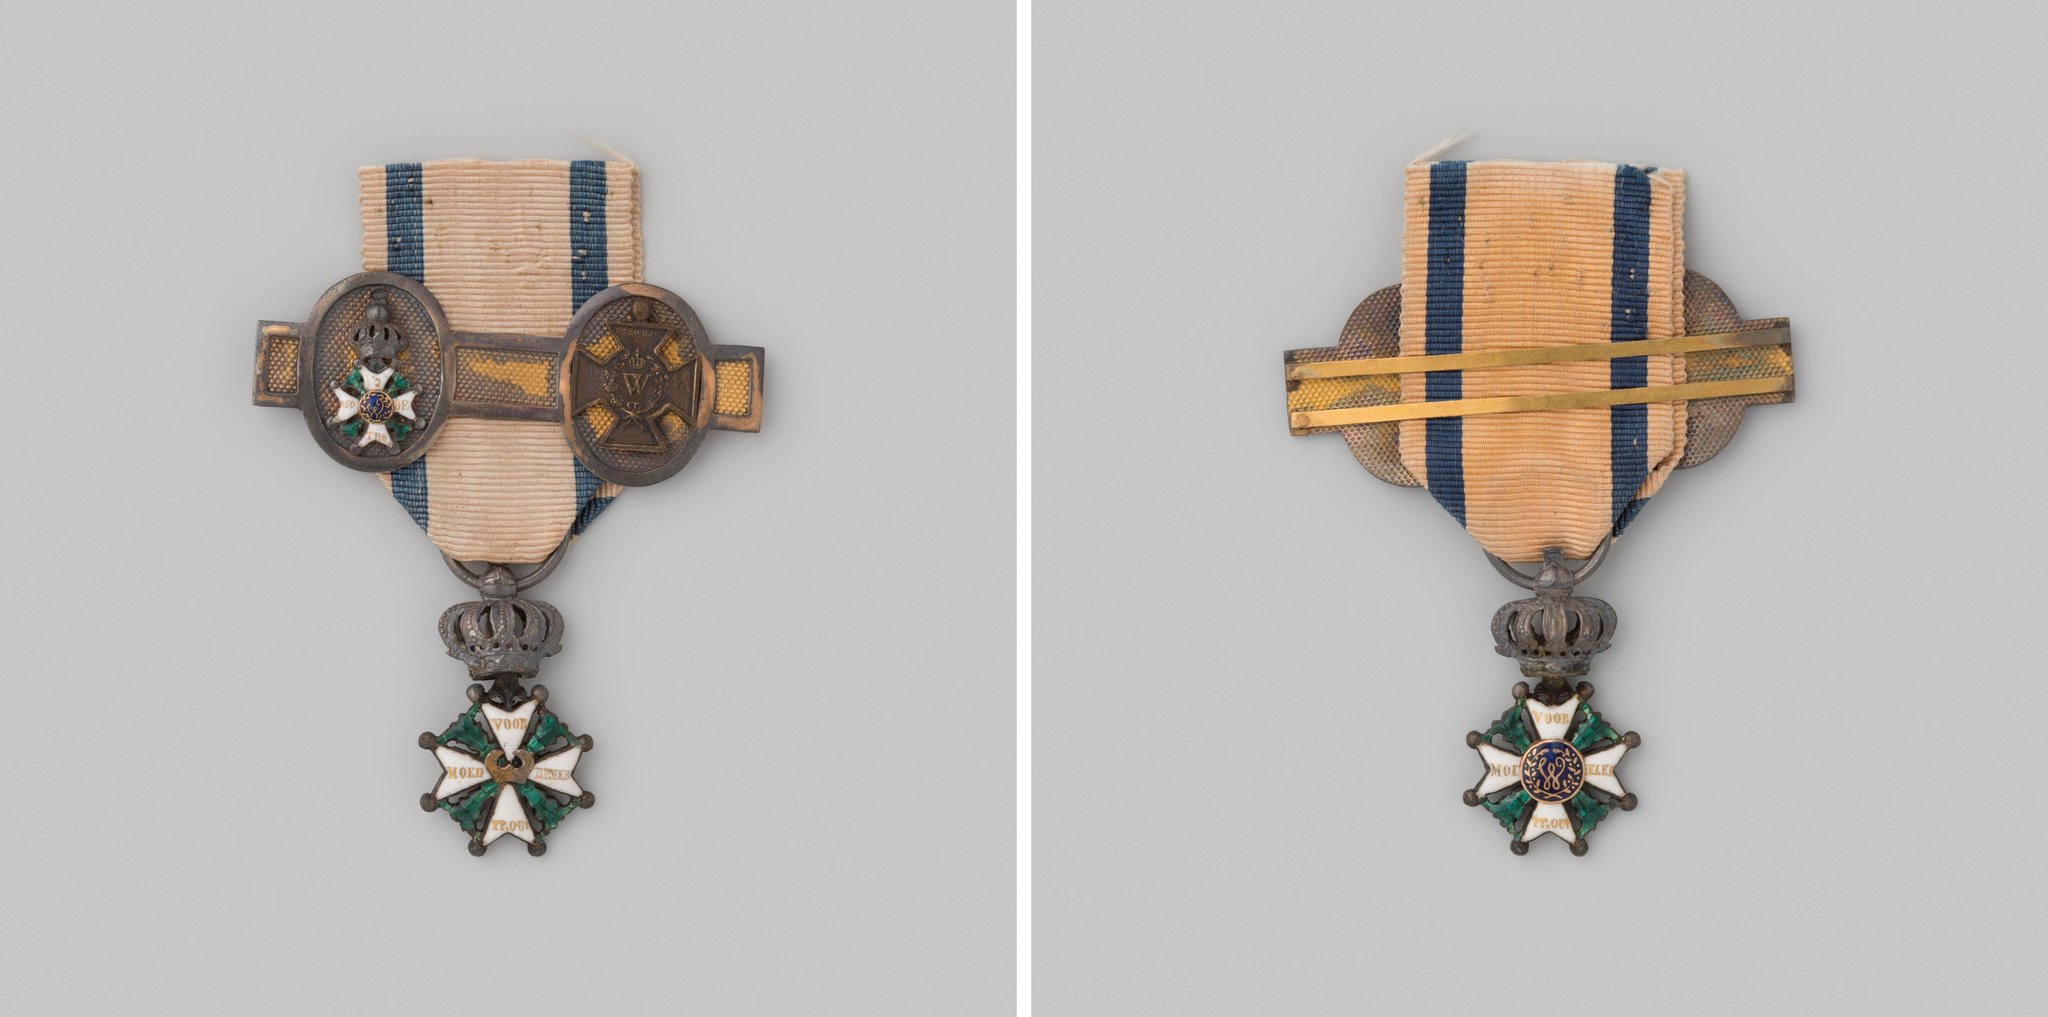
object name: ereteken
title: Ridderkruis 4e klasse van de Militaire Willemsorde voor moed, beleid en trouw, tweede kruis op gouden gesp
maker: Anonymous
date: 1815-1831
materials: gold, silver, textile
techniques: gilding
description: Zilveren draagteken met verguldsel, email, knop en lint. Aan het lint een tweede kruis op gouden gesp.